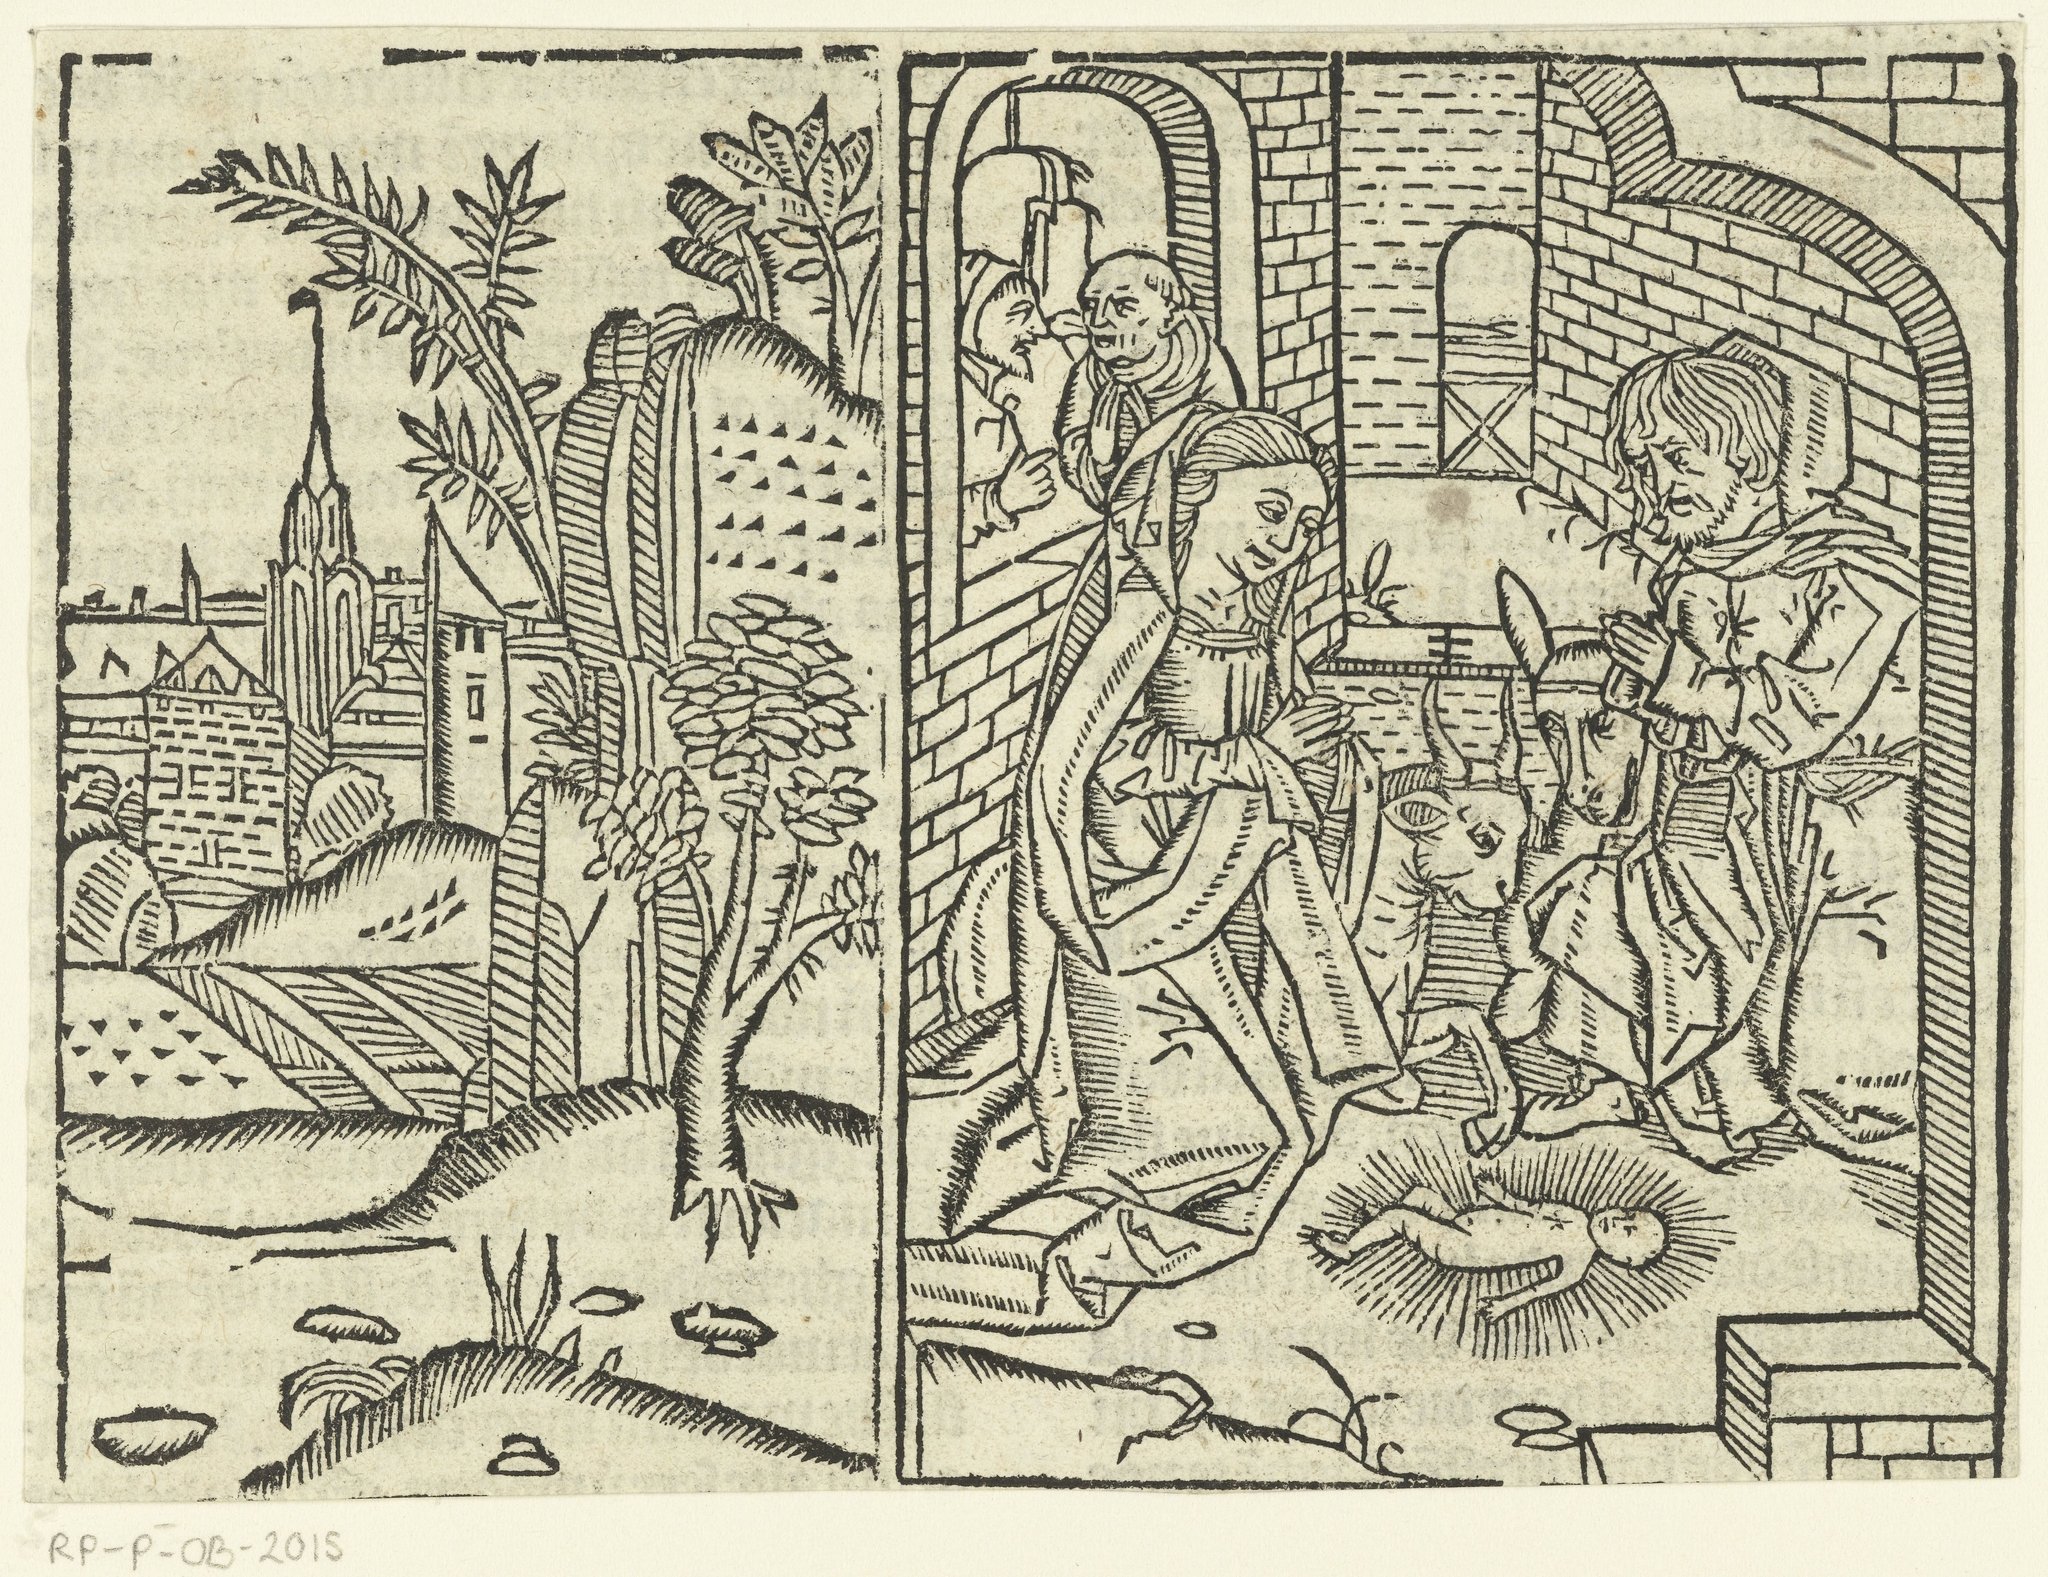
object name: print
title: Geboorte van Christus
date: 1480-1500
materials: paper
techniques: woodcut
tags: city-view, and landscape with man-made constructions, mary, joseph and the new-born christ (nativity)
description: Eén blad van 113 uit Ludolphus de Saxonia, "Dit es dleué ons liefs heeren ihesu christi". Anonieme Nederlandse vertaling. Uitgegeven door Henrick Eckert van Homberch te Antwerpen in 1503. Botke, K. Deze 113 houtsneden, die meestal reeds in vroege Nederlandse boeken gebruikt zijn, worden toegeschreven aan de tweede Meester van Delft, de Meester van de Delbecq-Schreiber-passie en de Meester van de Virgo inter Virgines. In Conway (1884) en in "De gulden passer"(1951) zijn ook eerdere versies opgenomen. Botke, K.